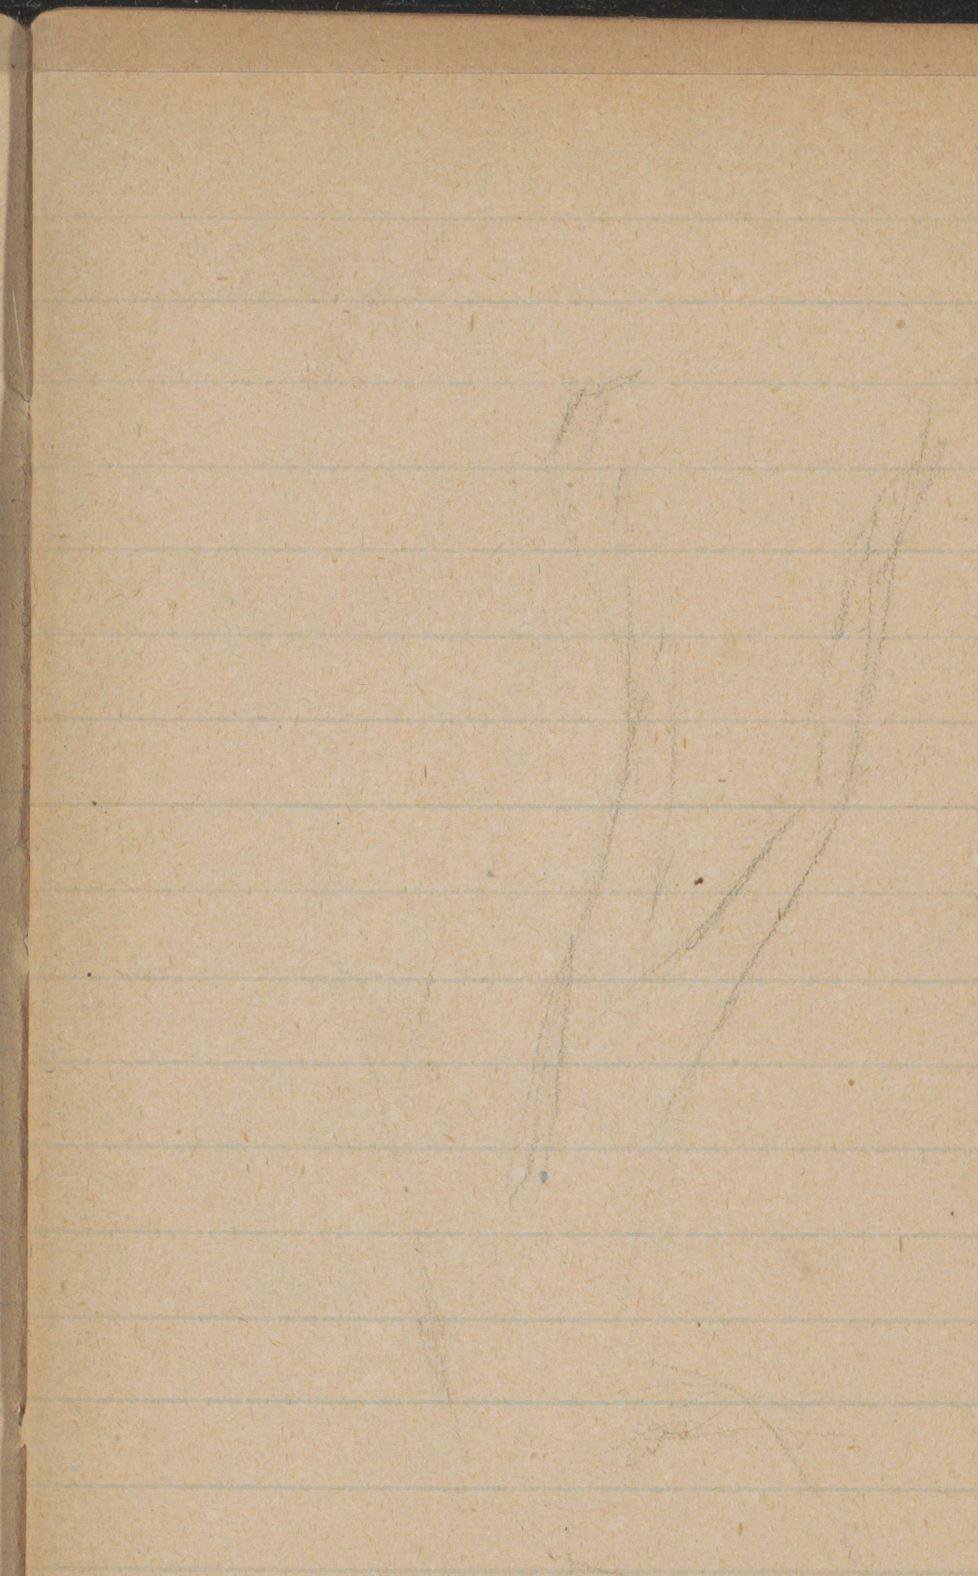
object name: sketchbook leaf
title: Figuurstudie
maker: marius bauer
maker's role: draughtsman, print maker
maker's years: 1867-1932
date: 1894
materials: chalk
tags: standing figure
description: Pagina 11 uit een schetsboek met 48 bladen.